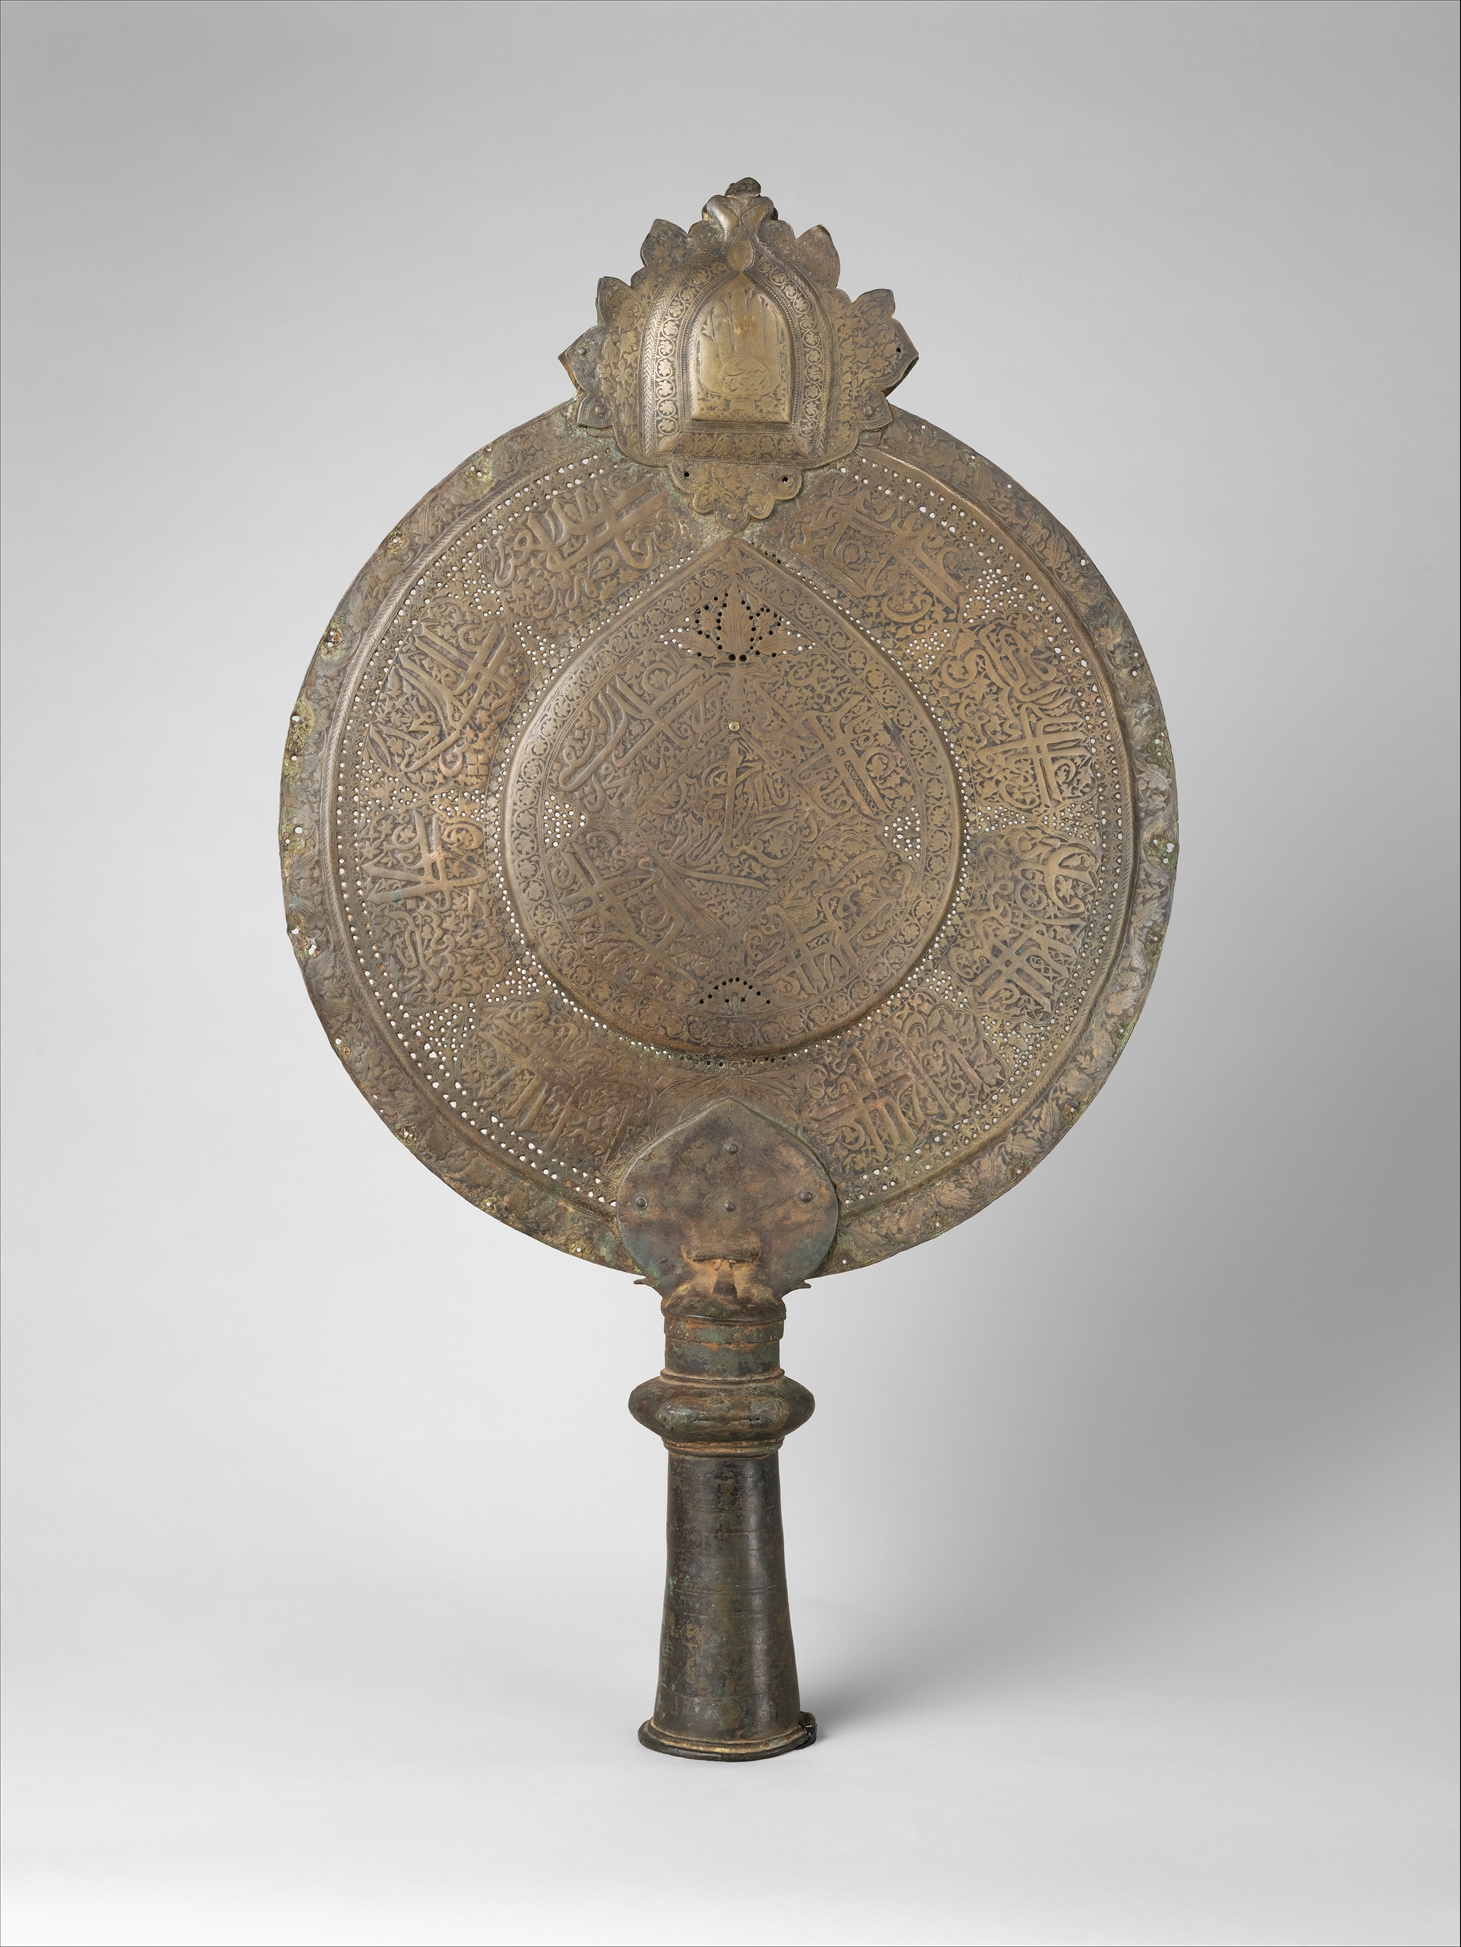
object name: standard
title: Fragment of a Processional Standard ('Alam)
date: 1567-1600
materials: brass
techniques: relief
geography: india